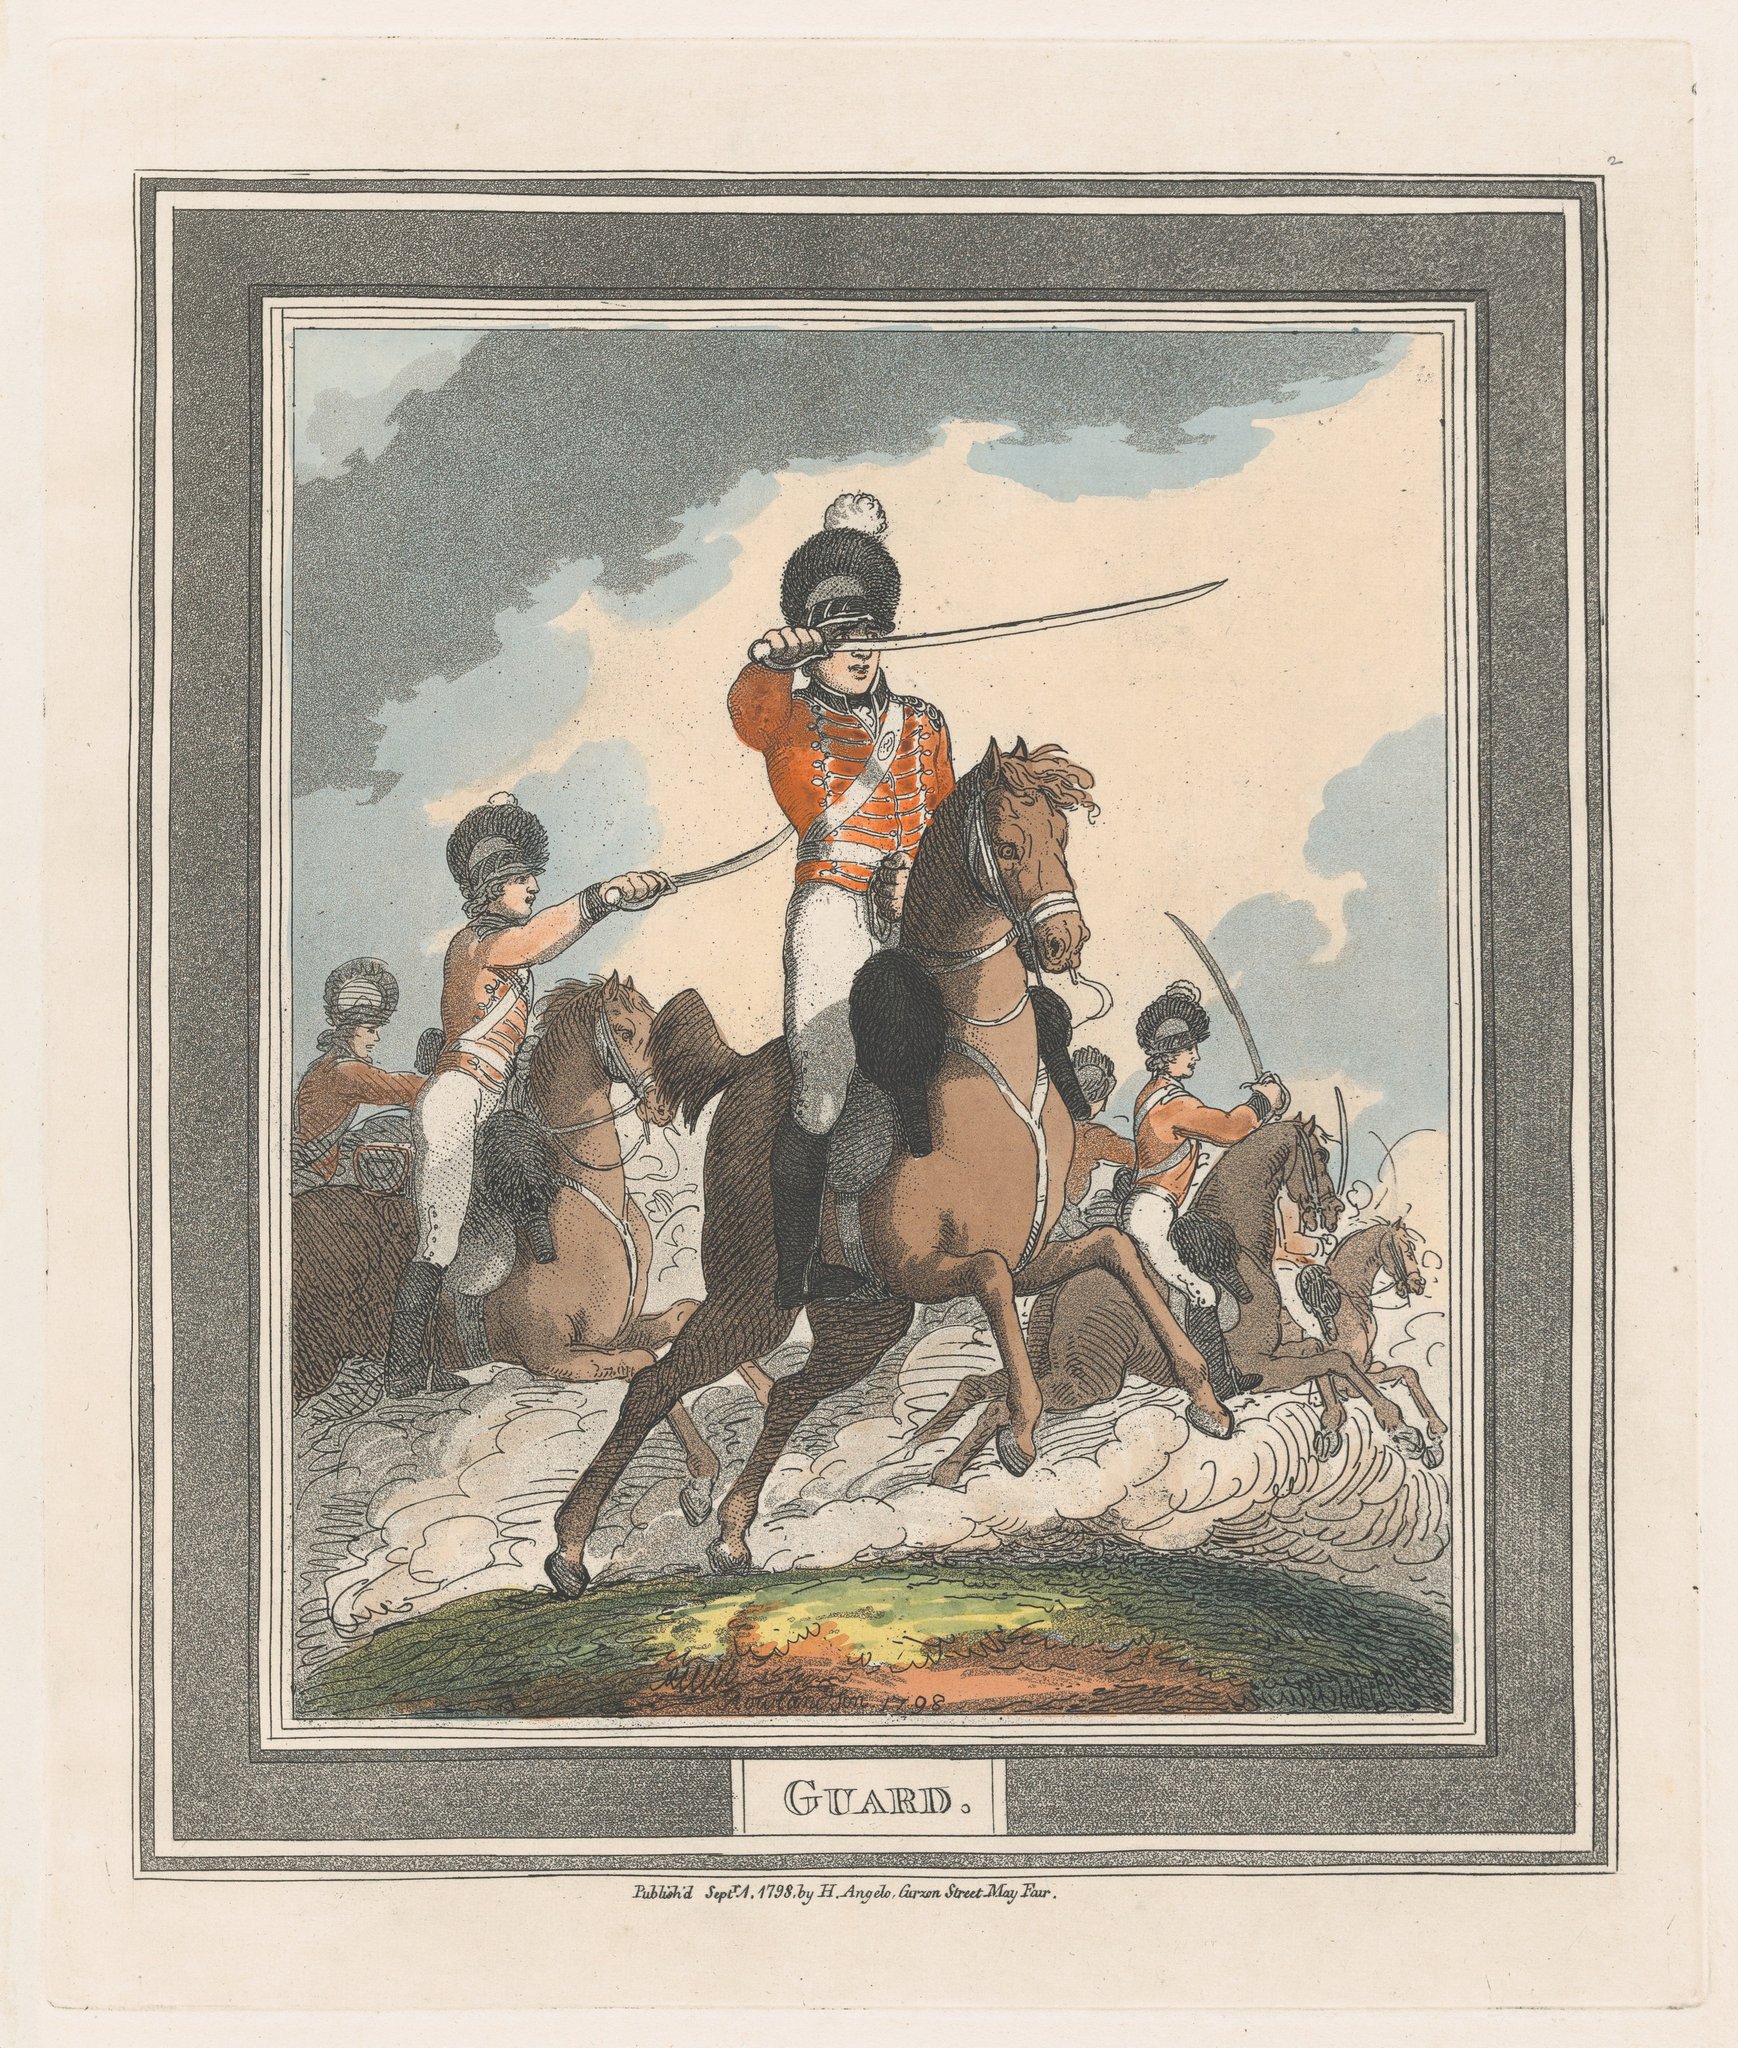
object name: print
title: Guard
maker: thomas rowlandson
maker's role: artist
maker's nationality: british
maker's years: 1757-1827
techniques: aquatint, etching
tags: swords,men,horses